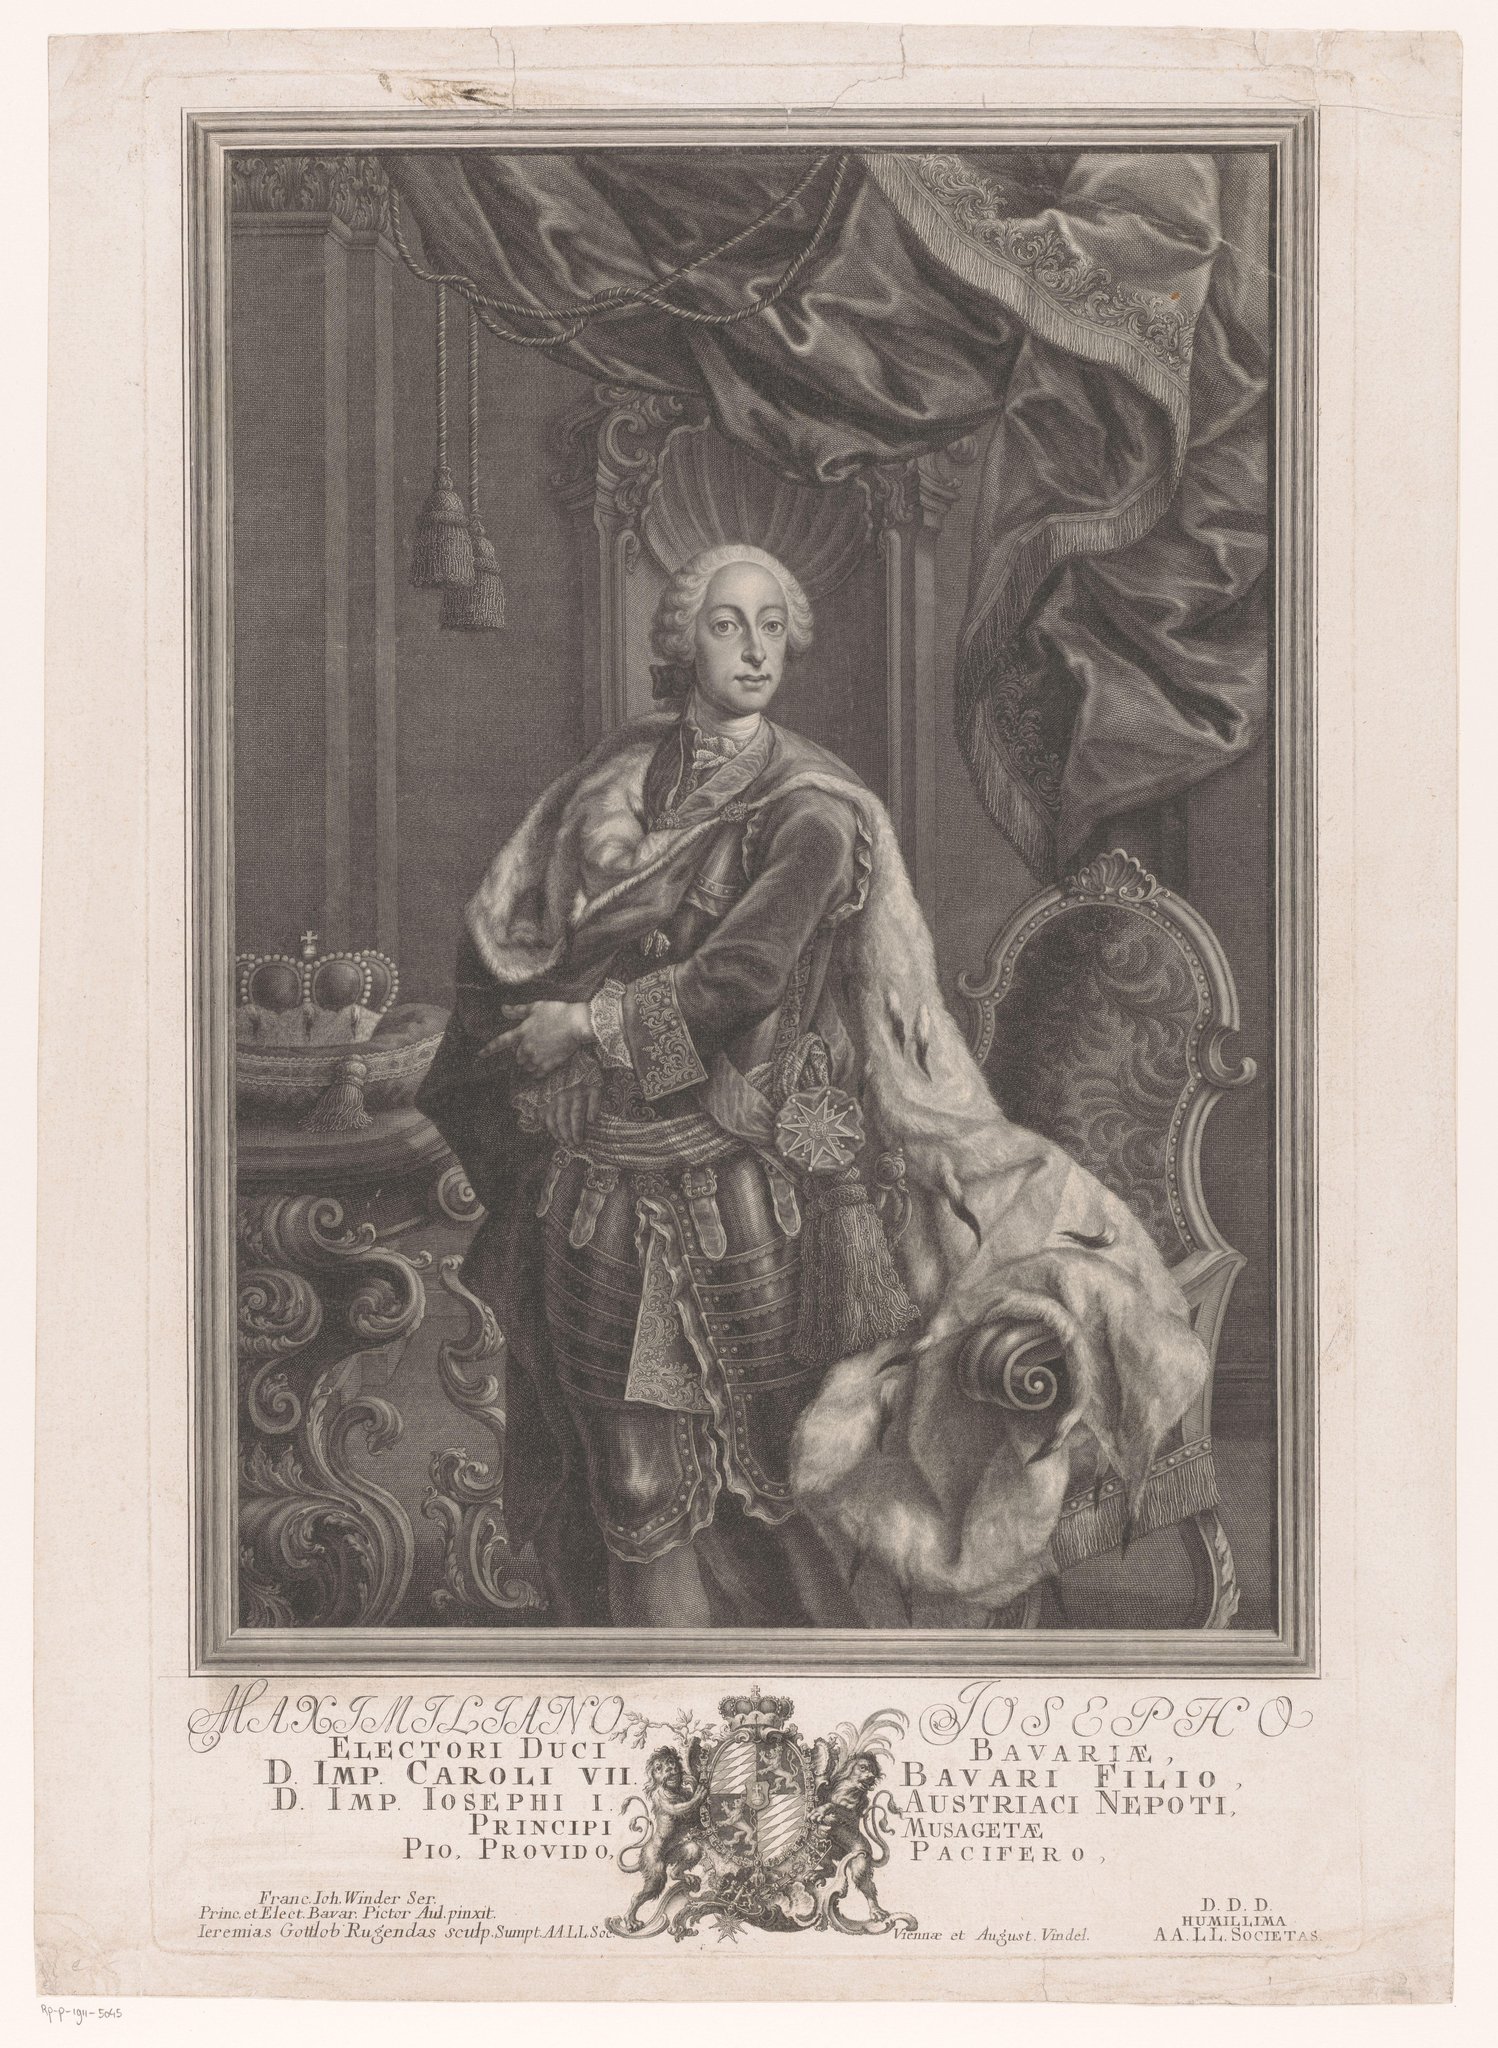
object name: print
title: Portret van Maximilian III Joseph, keurvorst van Beieren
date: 1720-1772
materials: paper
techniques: engraving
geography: vienna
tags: historical persons, knighthood order of the golden fleece, ruler, sovereign, armorial bearing, heraldry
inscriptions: collector's mark: Lugt 2228